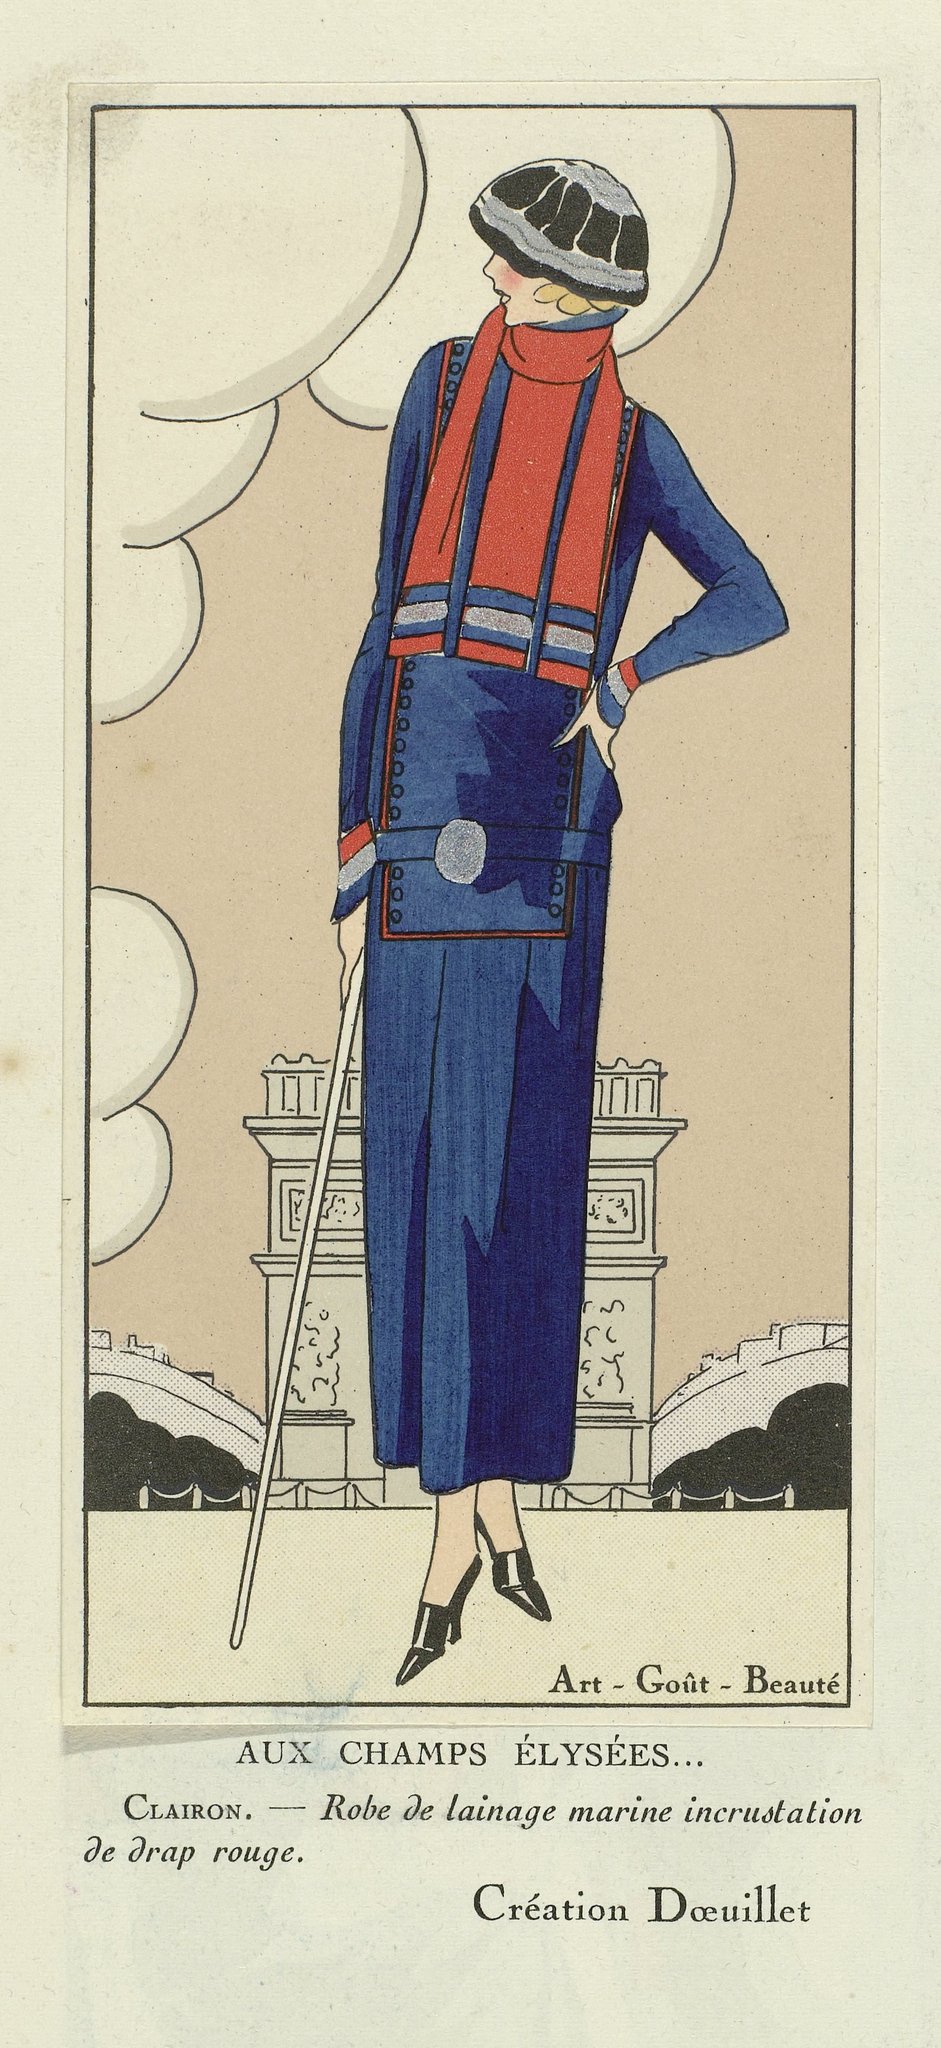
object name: magazine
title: Art - Goût - Beauté, Feuillets de l' élégance féminine, Janvier 1924, No. 41, 4e Année, p. 14 : Aux Champs Elysées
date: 1924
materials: paper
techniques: brush, hand coloring, lithograph, pochoir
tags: walking-stick, staff, cane (+ women's clothes), neck-gear ~ clothing (shawl) (+ women's clothes), fashion plates, head-gear: hat (+ women's clothes), dress, gown (+ women's clothes)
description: Vrouw in een jurk van marineblauwe wol en rood laken, van Doeuillet. Deel van een pagina uit het modetijdschrift Art-Goût-Beauté (1920-1933).